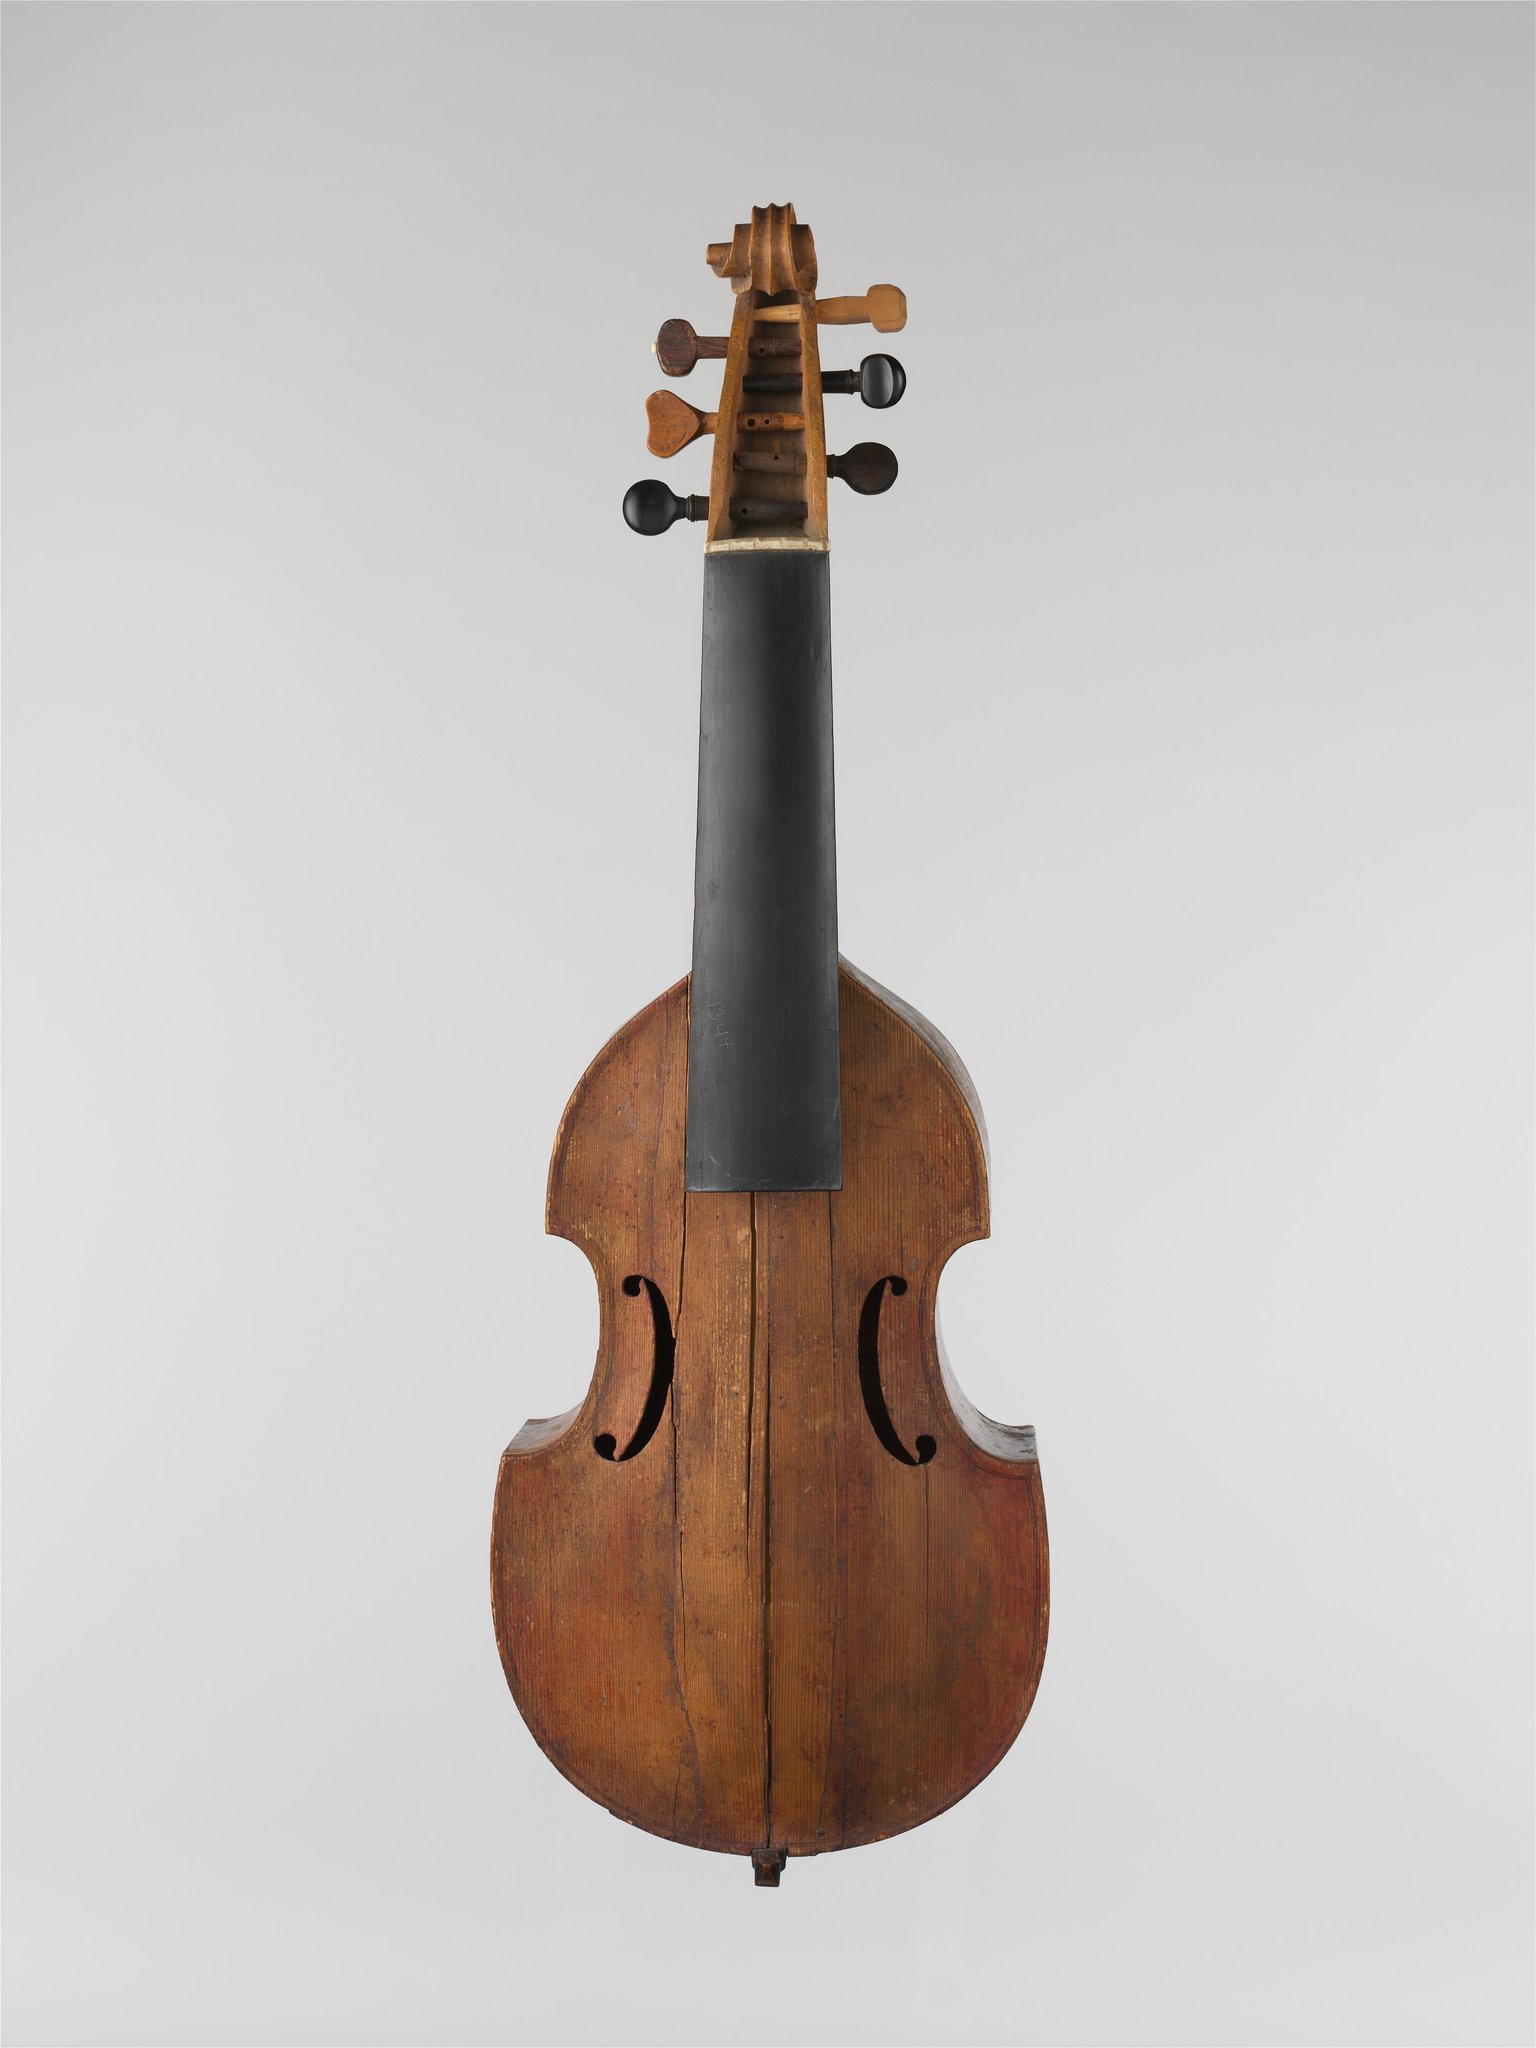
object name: treble viol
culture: french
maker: jean villiaume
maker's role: maker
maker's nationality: french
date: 1743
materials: wood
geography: france